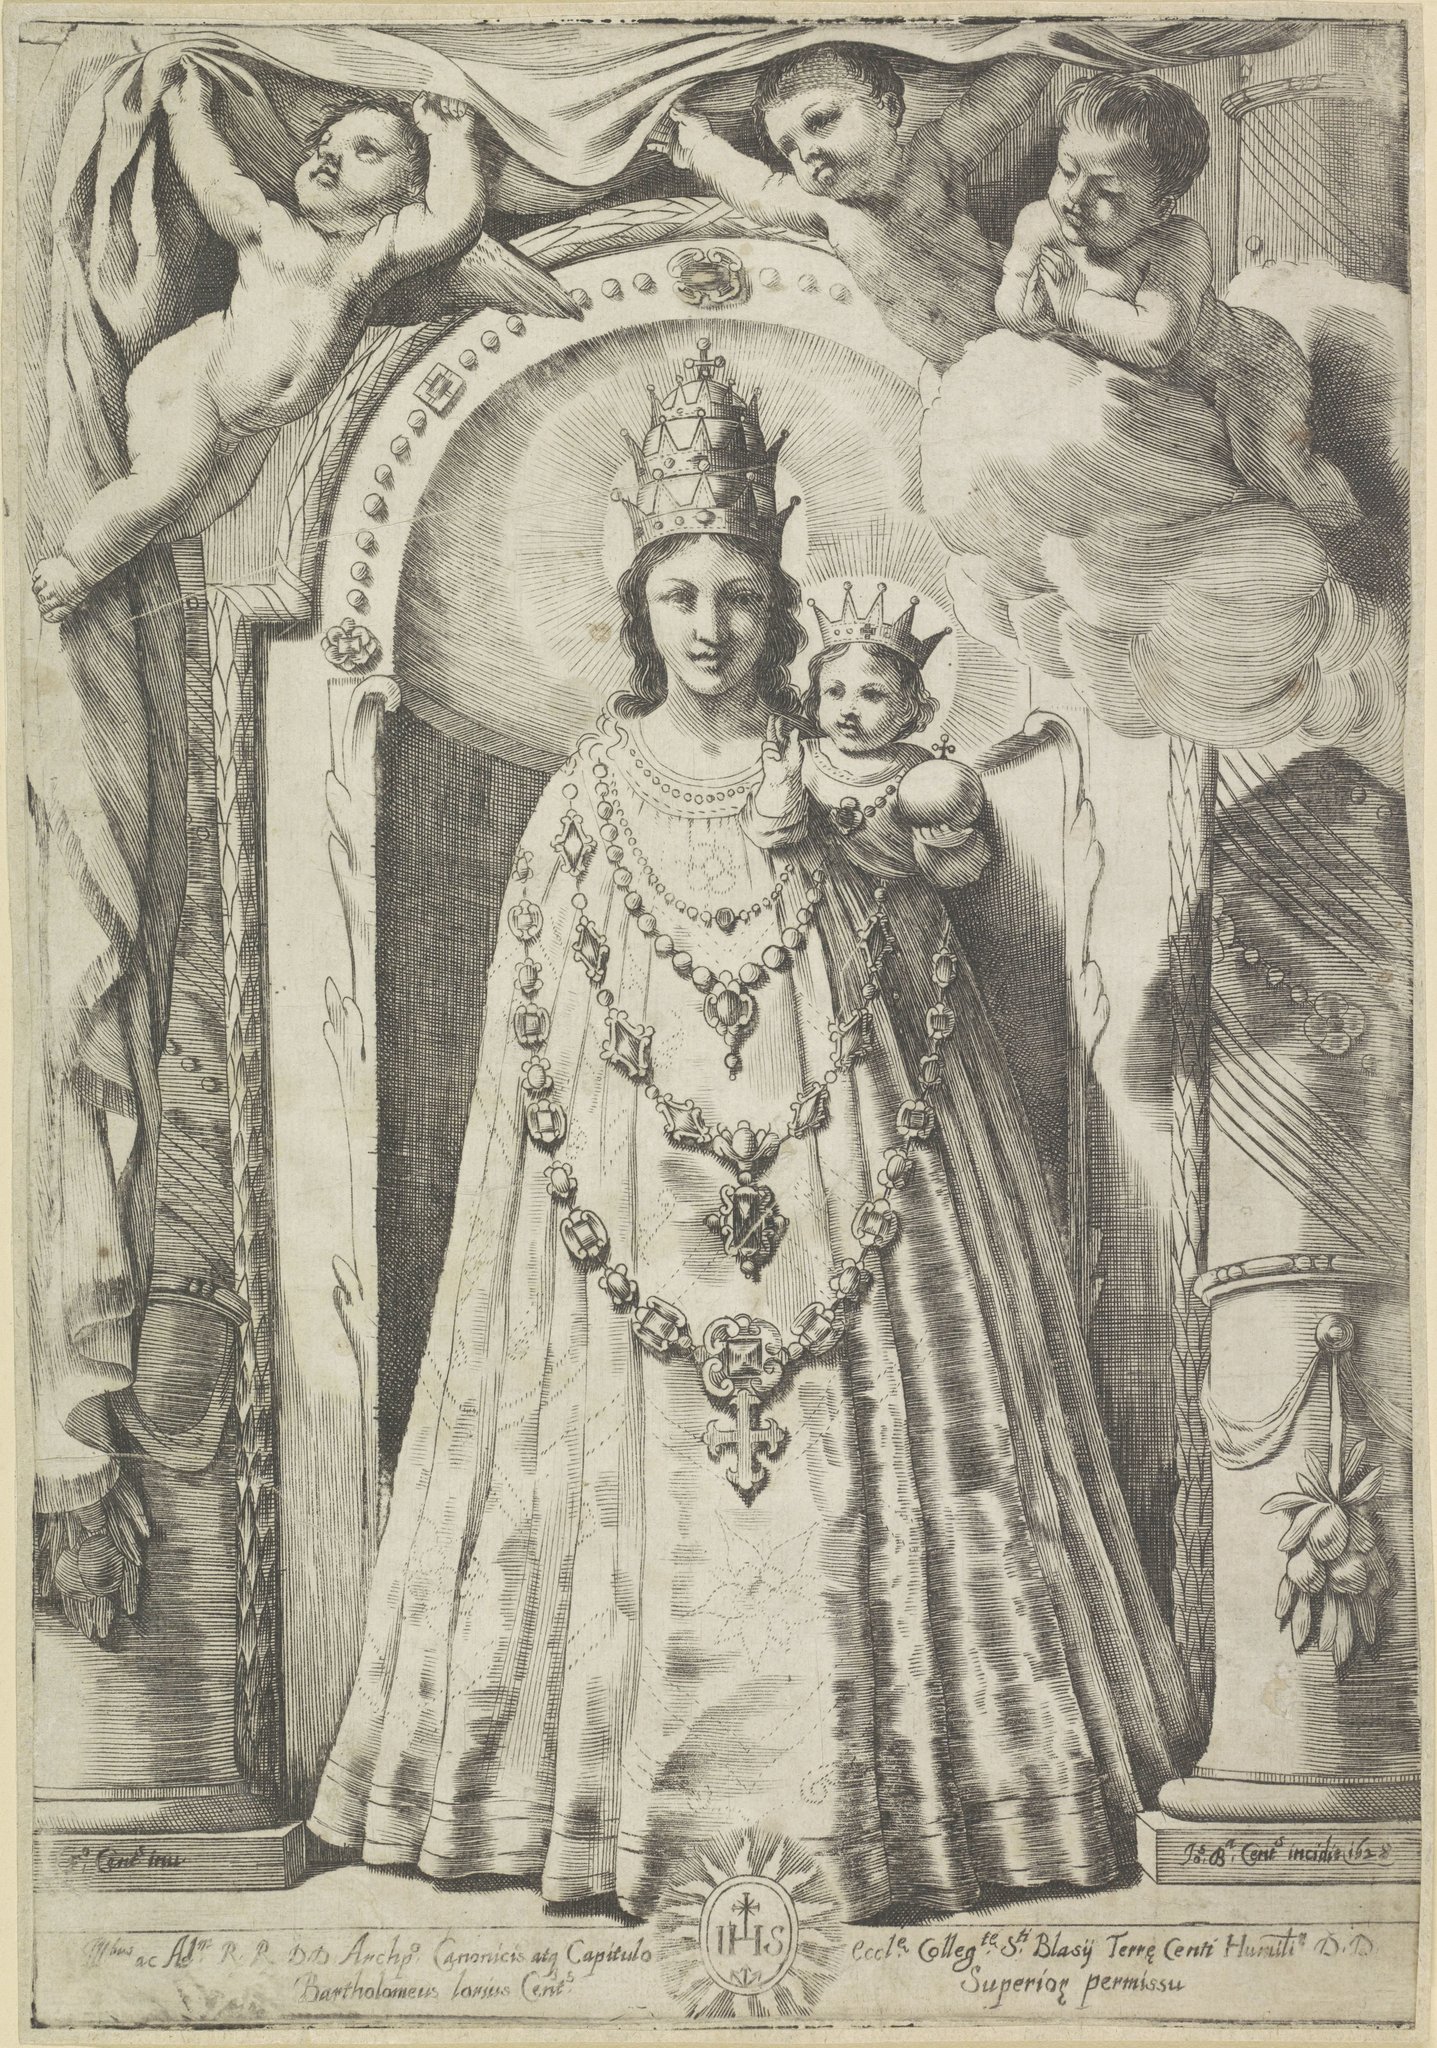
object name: print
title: Beeld van Maria met Kind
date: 1628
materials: paper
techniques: etching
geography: italy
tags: mary standing (or half-length), the christ-child on her arm (christ-child to mary's left) - ff - the christ-child to mary's right, mary devotion, cupids: 'amores', 'amoretti', 'putti'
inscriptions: collector's mark: Lugt 240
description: Een beeld van Maria met Kind in een nis. Het beeld is versierd met kronen en juwelen. Boven de nis zweven putti. Tekst in ondermarge.